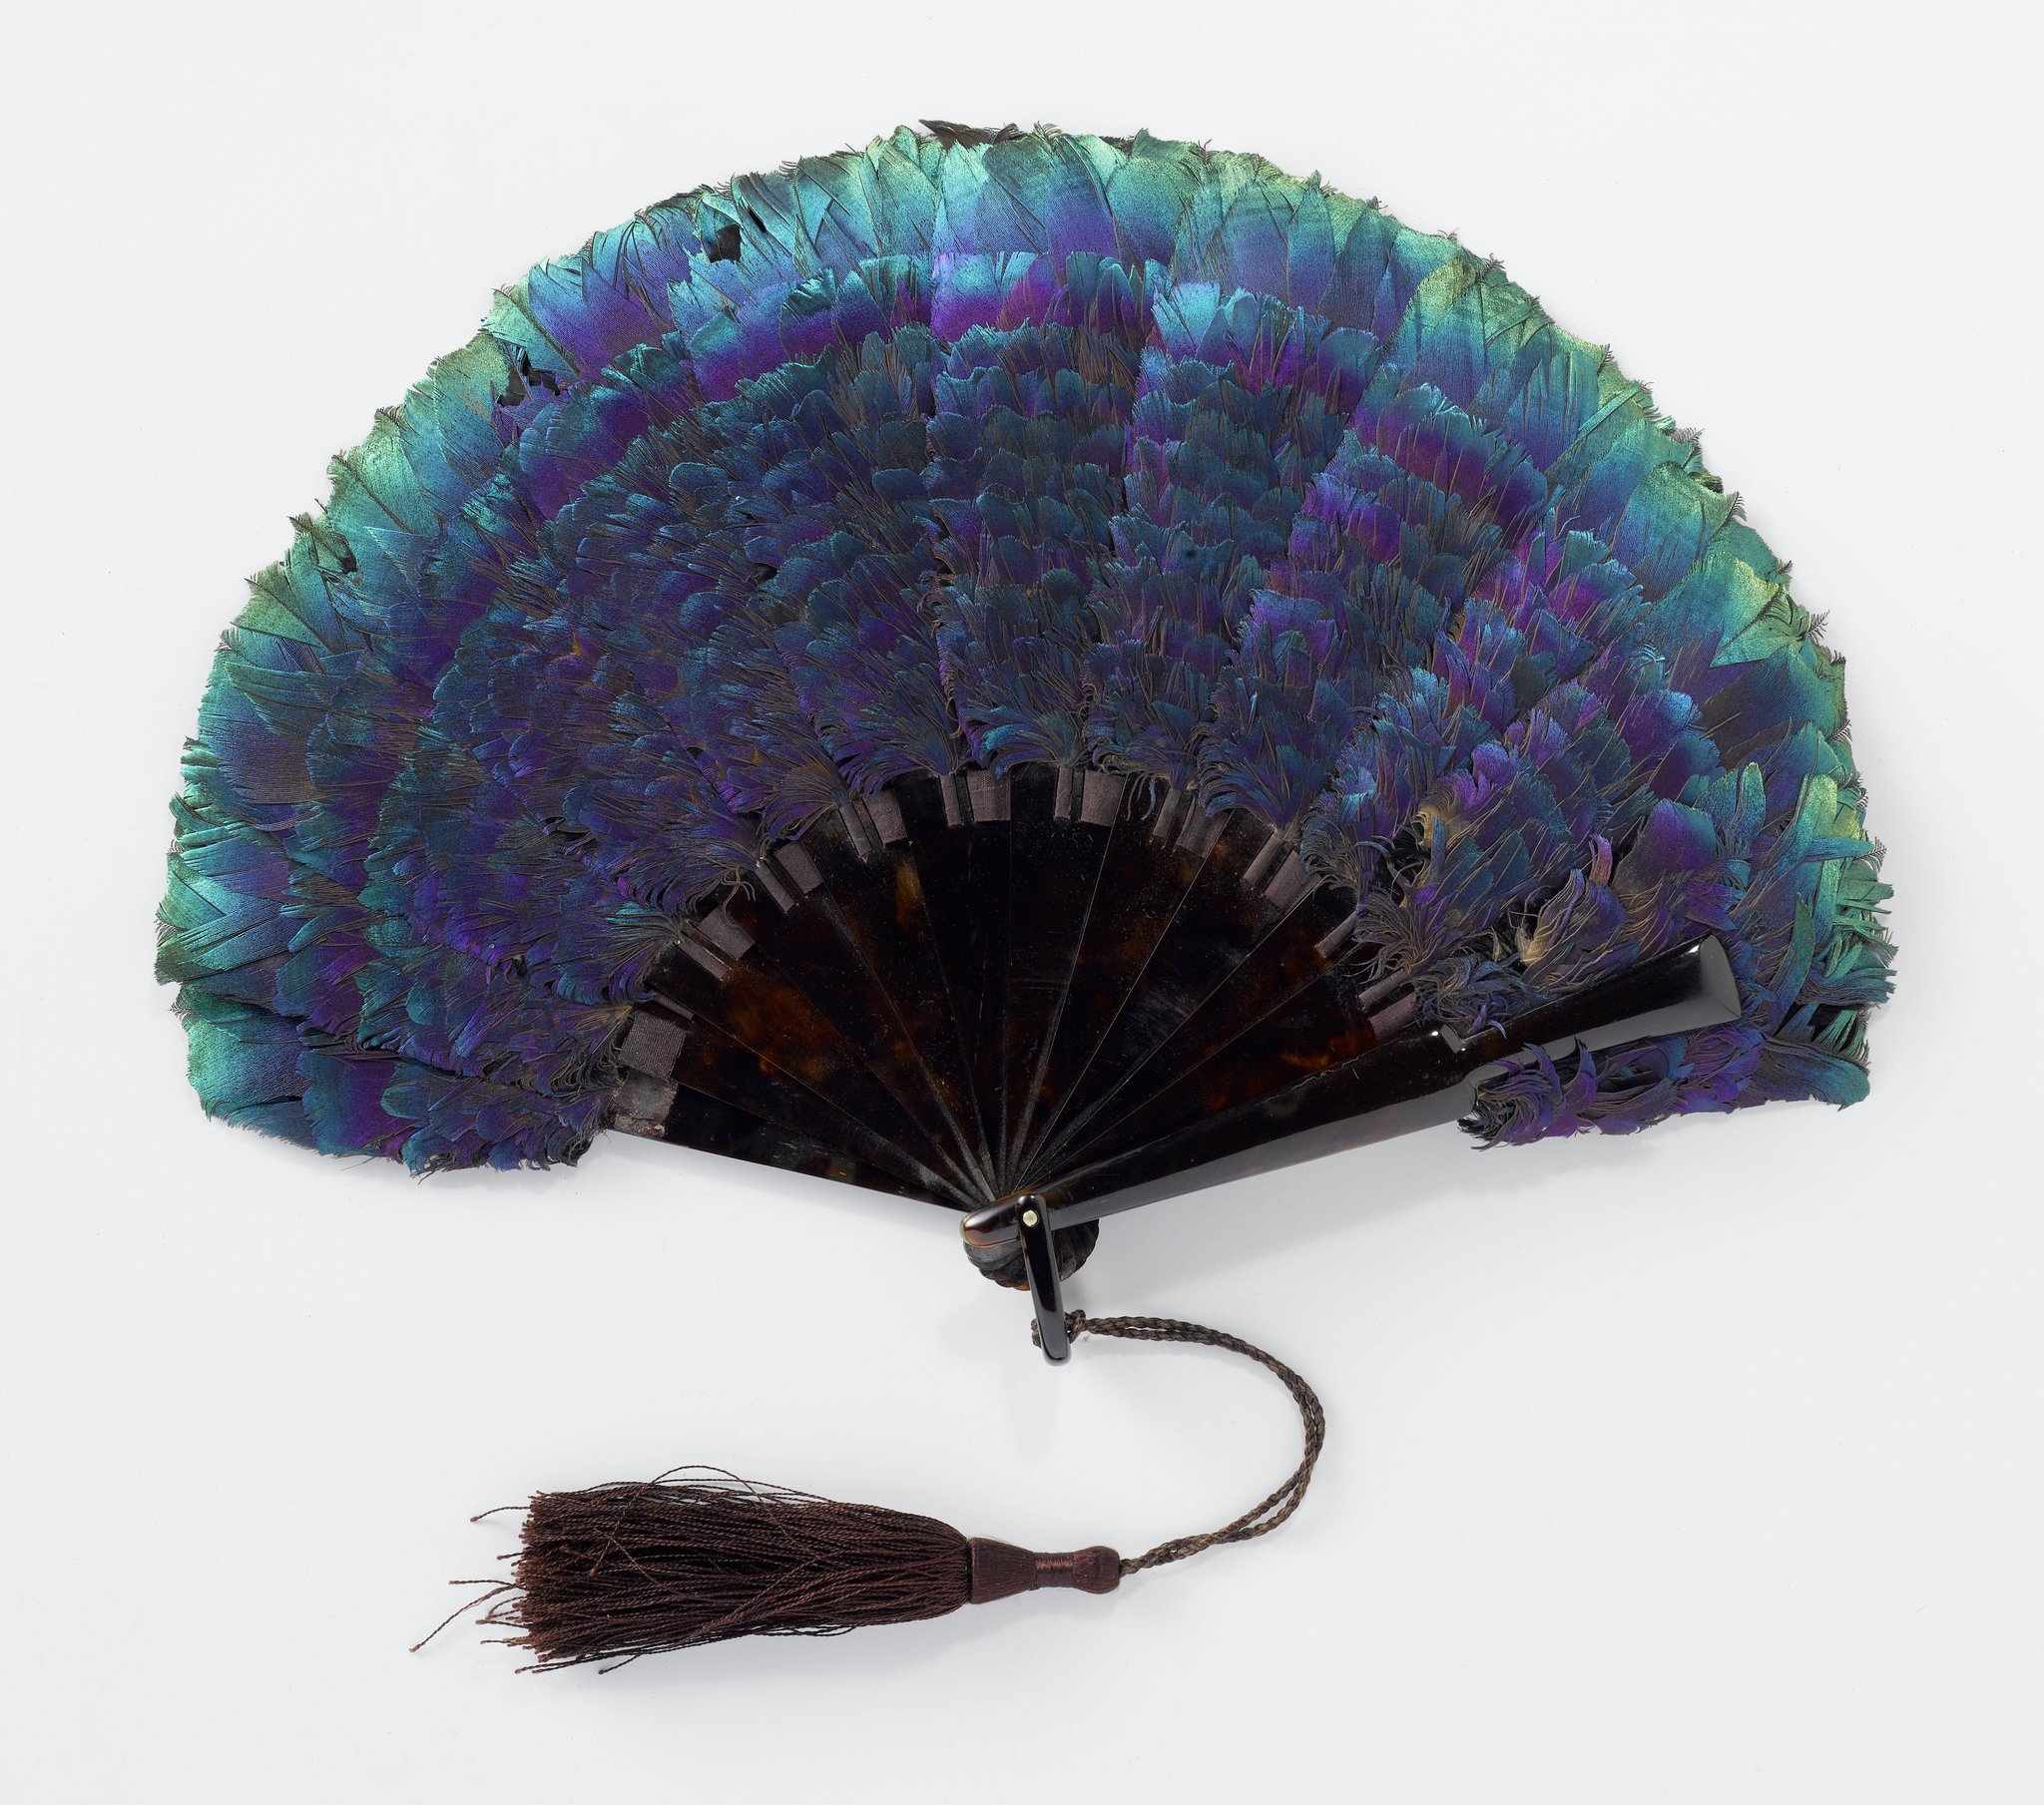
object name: vouwwaaier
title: Waaier met iriserende veren van de glansfazant op een montuur van imitatie schildpad met koord en kwast van zijde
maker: Anonymous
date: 1900-1910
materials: feather, plastic, silk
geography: france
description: Waaier met blauw-groene en paarse iriserende veren van de glansfazant (Lophophorus spec.) op een montuur van imitatie schildpad en dito ring met koord en kwast van zijde. 12 Aaneengesloten benen. Stalen sluitpin.